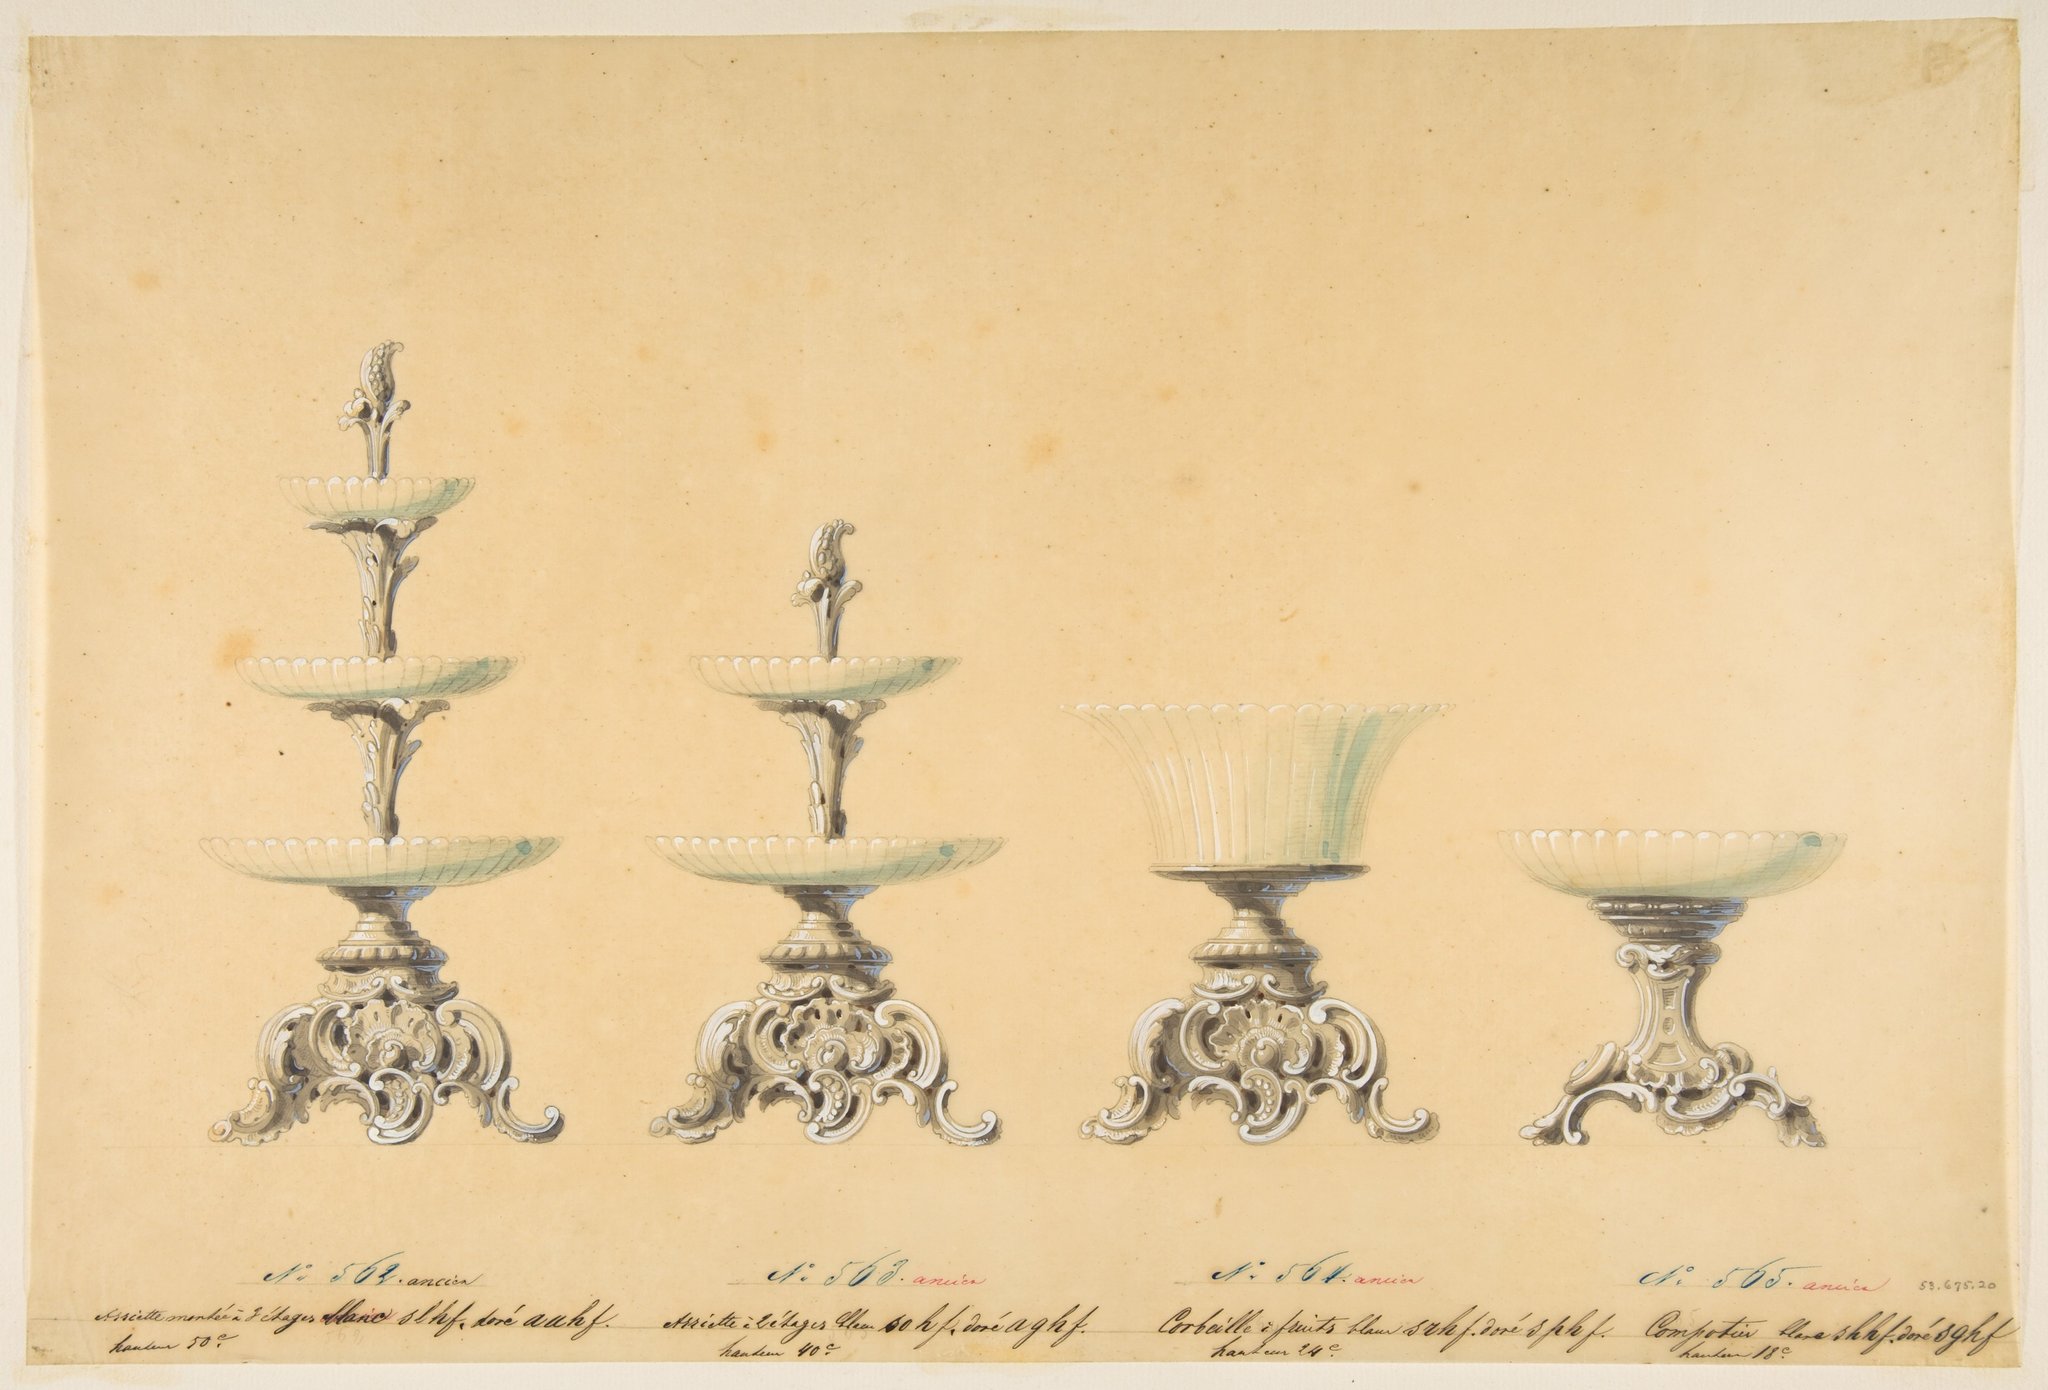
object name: drawing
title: Four Designs for Tiered Serving Dishes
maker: anonymous, french, 19th century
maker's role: artist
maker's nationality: french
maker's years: 1800-1900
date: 1801-1900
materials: gouache, graphite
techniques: brush, wash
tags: dishes